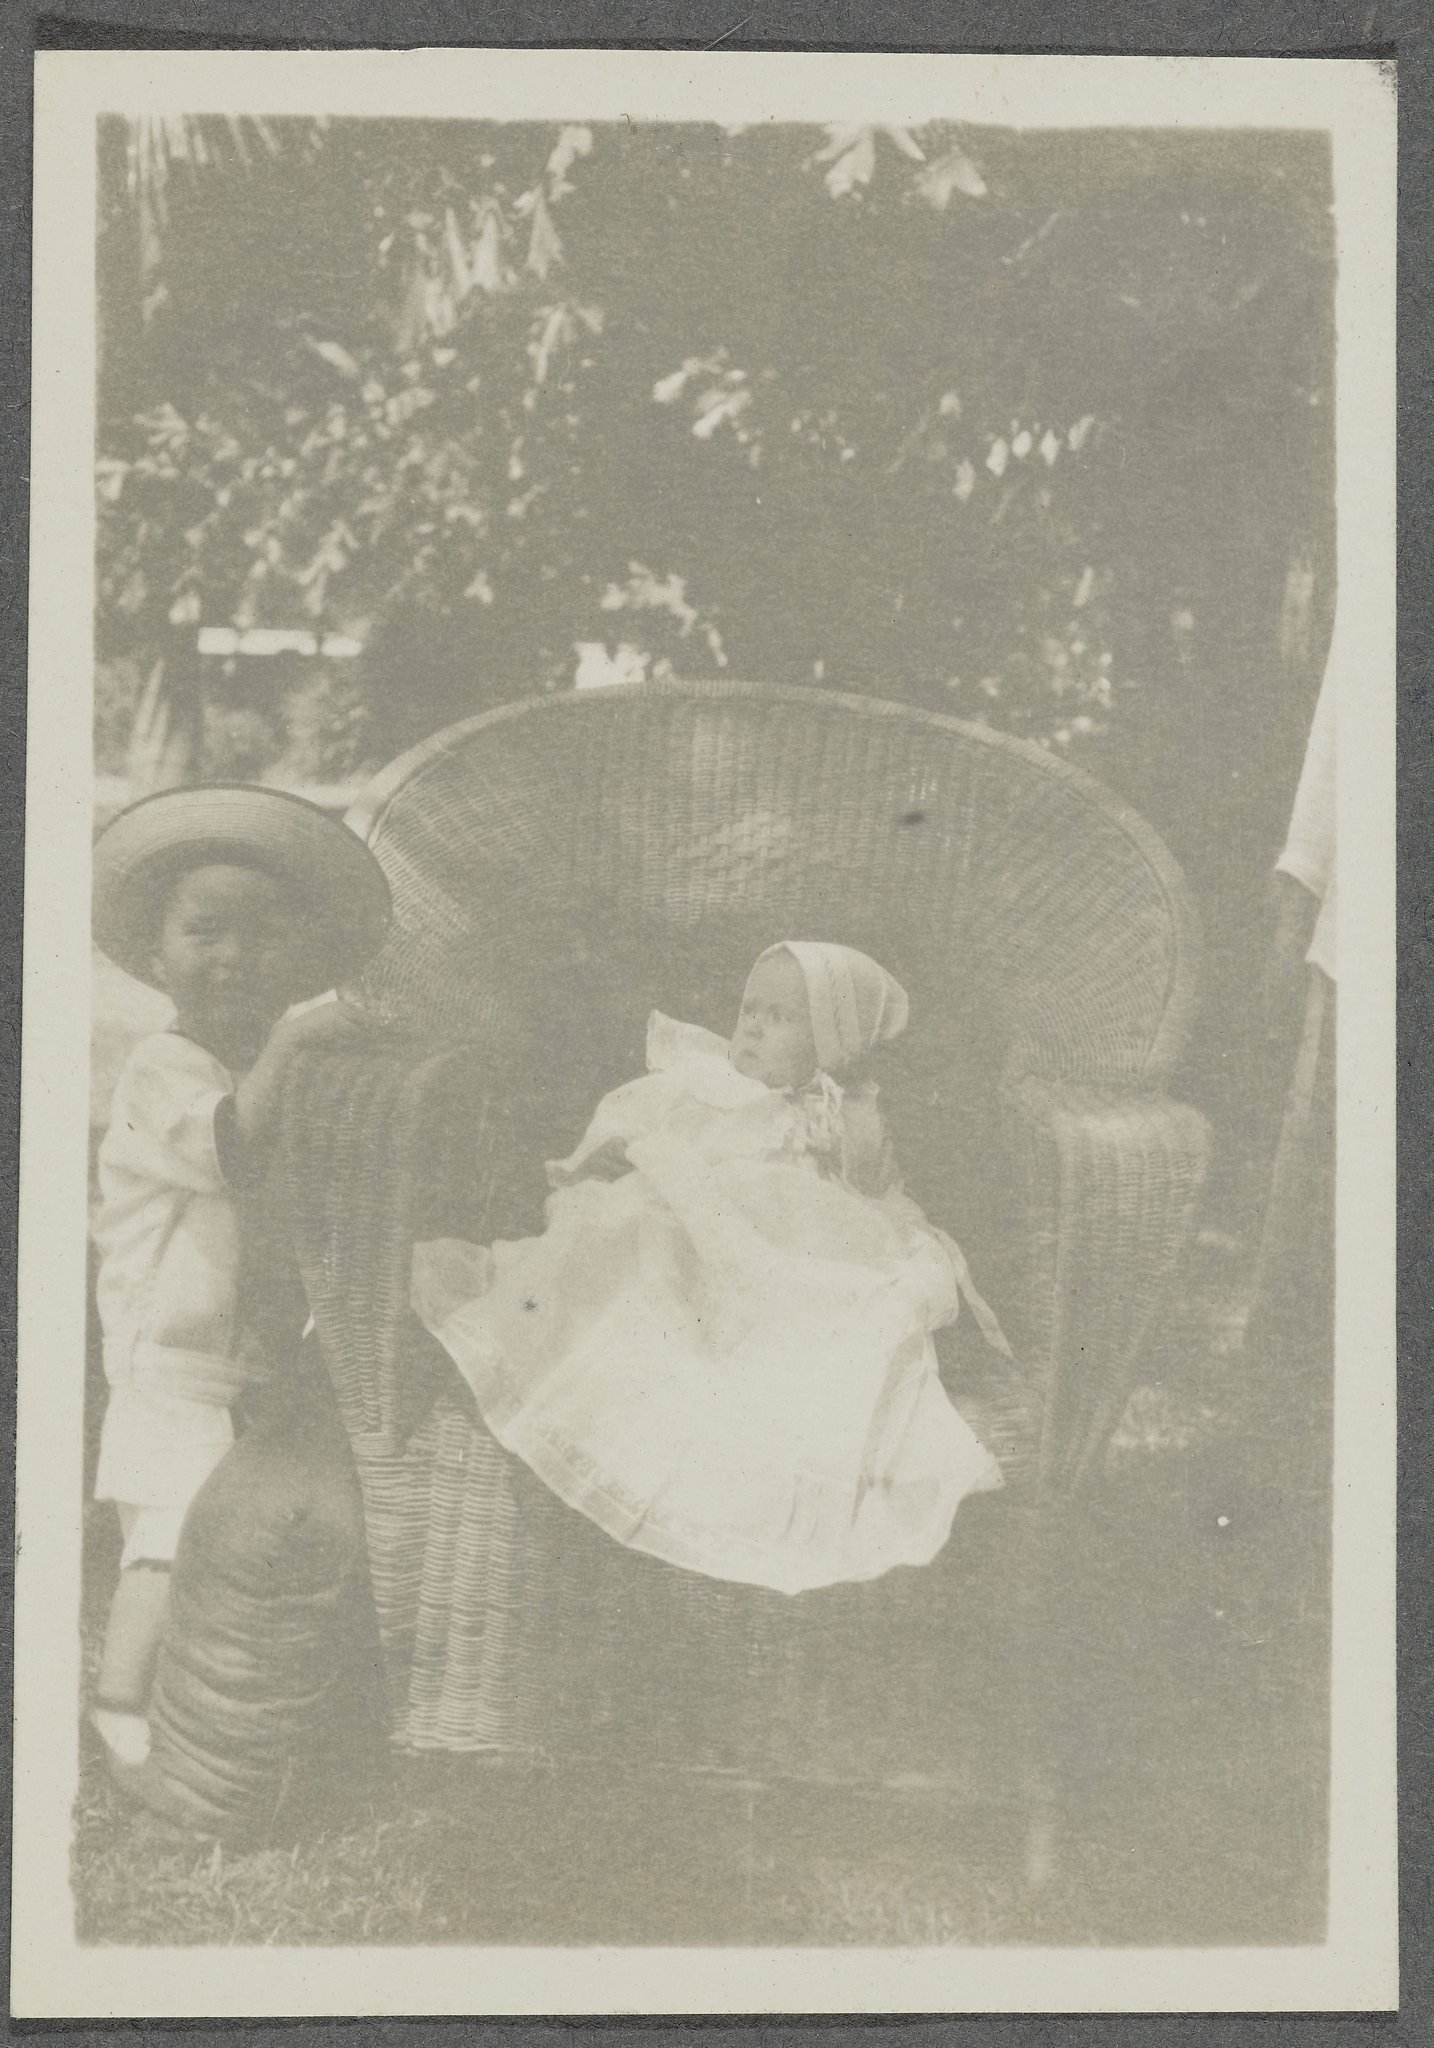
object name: photograph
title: Klaas en Tiny Kleiterp in een tuin in Pangka op Java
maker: klaas kleiterp (i)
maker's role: arts, officier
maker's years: 1892-1943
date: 1912-1921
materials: paper, photographic support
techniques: daylight paper print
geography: pangka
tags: garden, child, infant, baby ~ the ages of man, brothers or sisters (second degree family relationships), dutch east indies, the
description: Onderdeel van Fotoalbum van de familie Kleiterp-Vermeulen met opnames van de kinderen Klaas en Tiny in Nederlands-Indië.